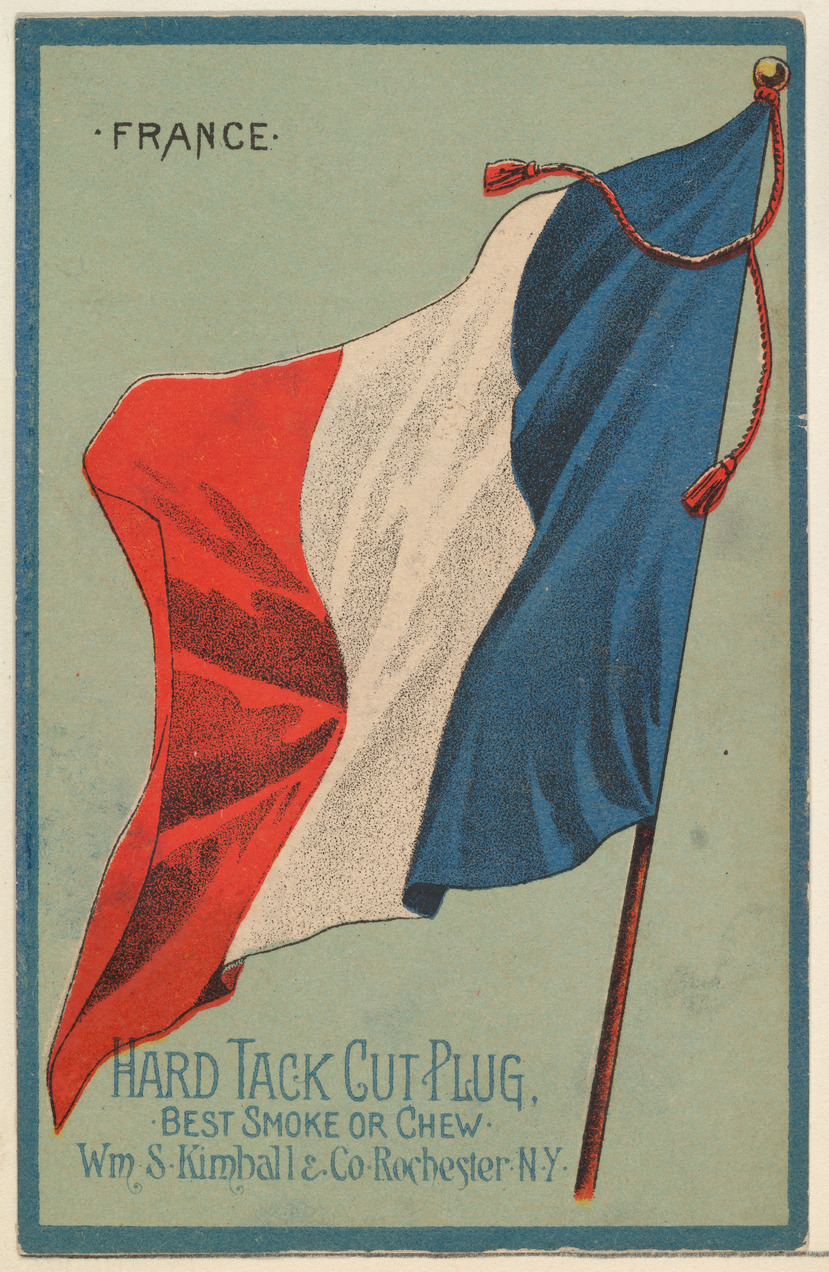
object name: print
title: France, from the National Flags series (N195) issued by Wm. S. Kimball & Co.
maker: william s. kimball & company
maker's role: publisher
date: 1891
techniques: color lithograph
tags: flags